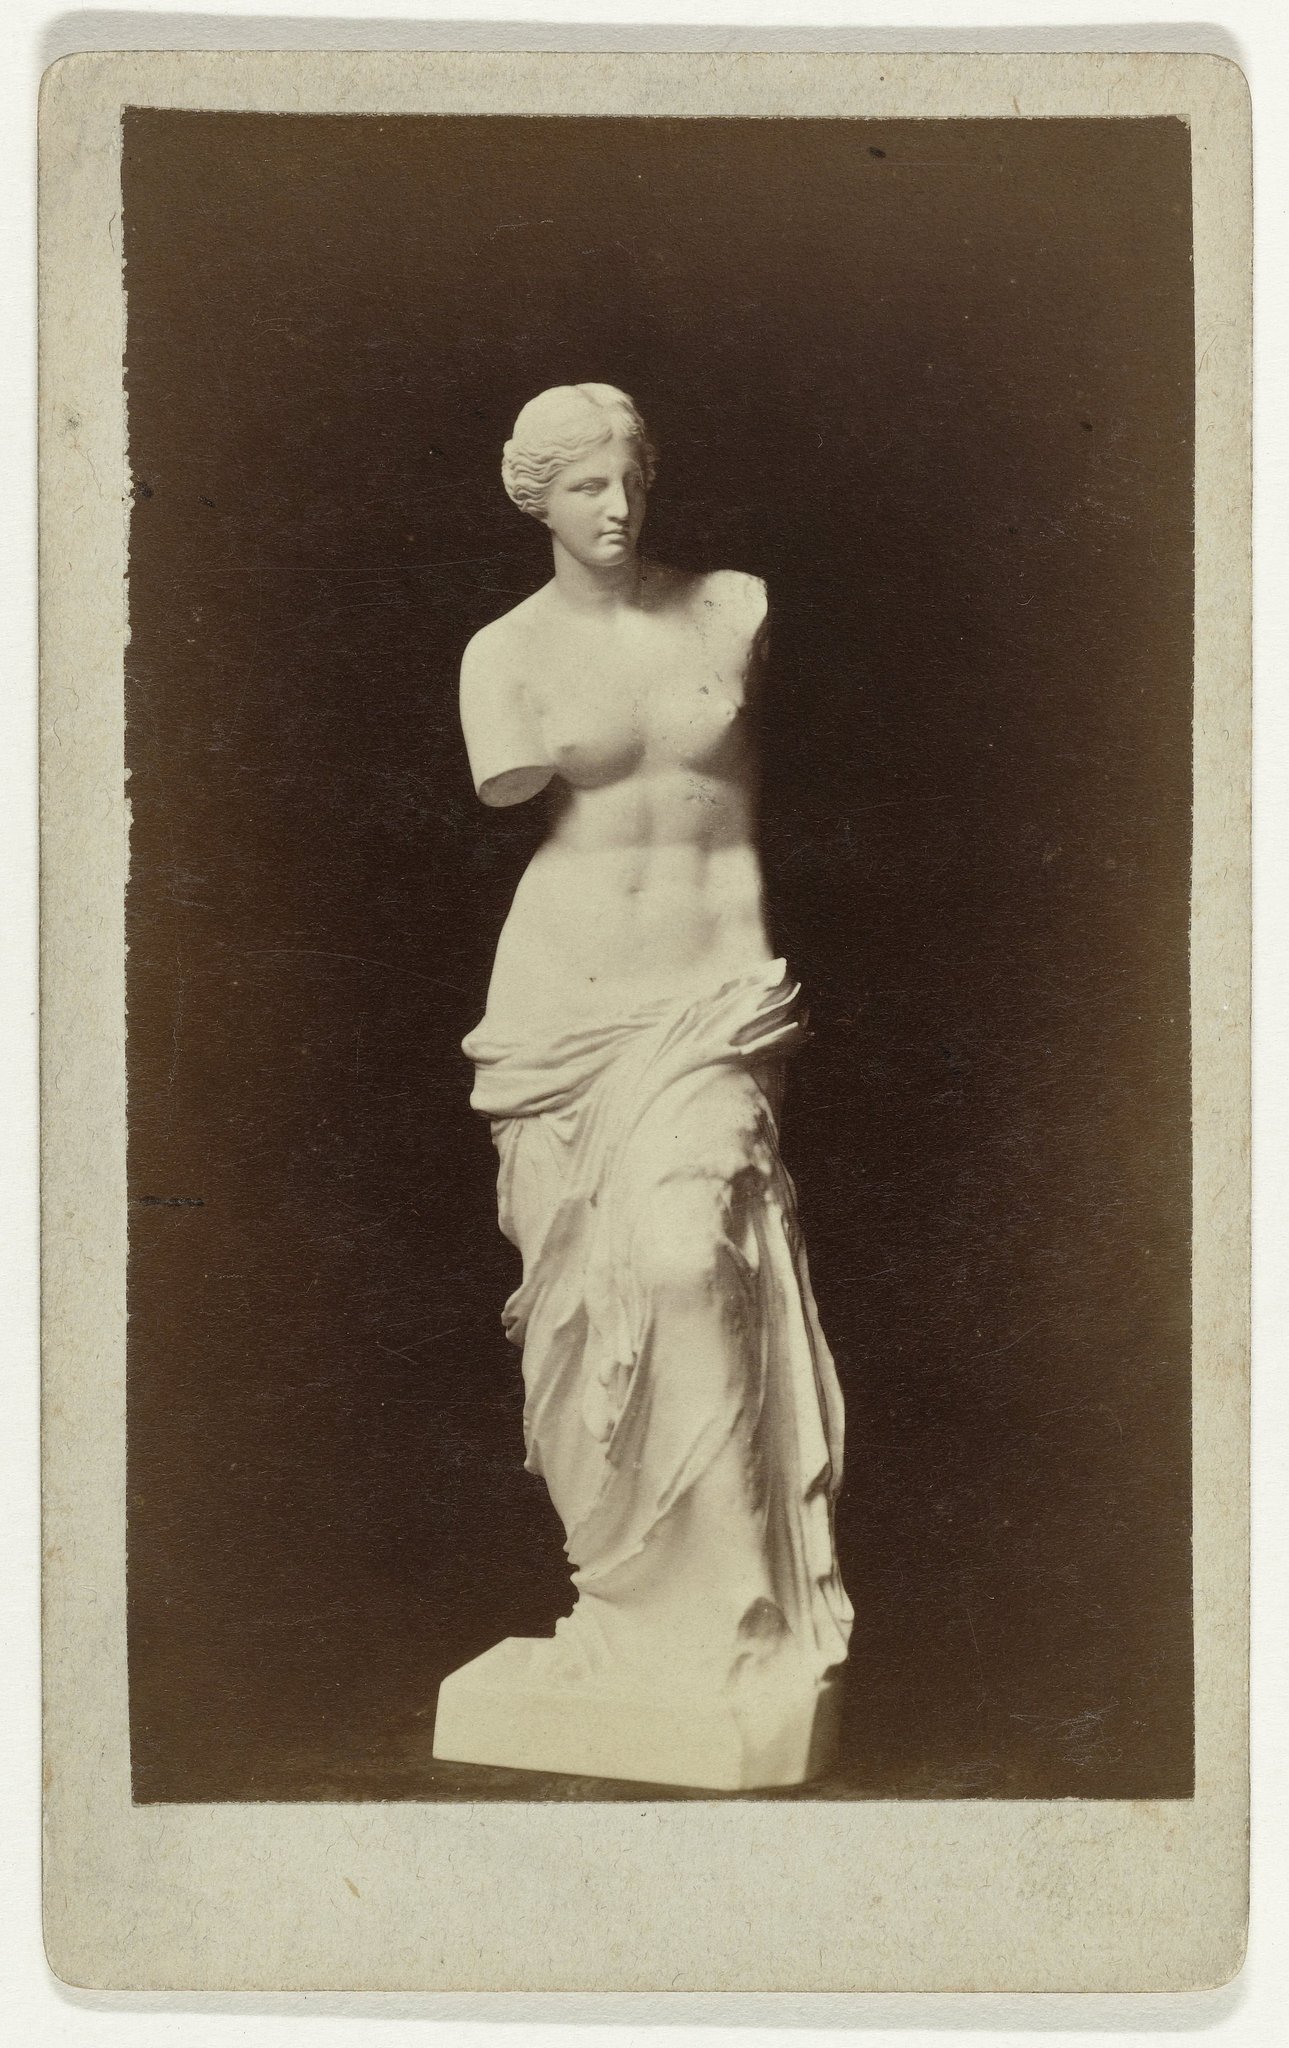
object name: carte de visite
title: (Replica van de) Venus van Milo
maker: Anonymous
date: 1870-1900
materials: cardboard, paper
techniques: albumen print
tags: piece of sculpture, reproduction of a piece of sculpture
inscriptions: title: ‘No. 452. // Venus van Milo. // antik.’